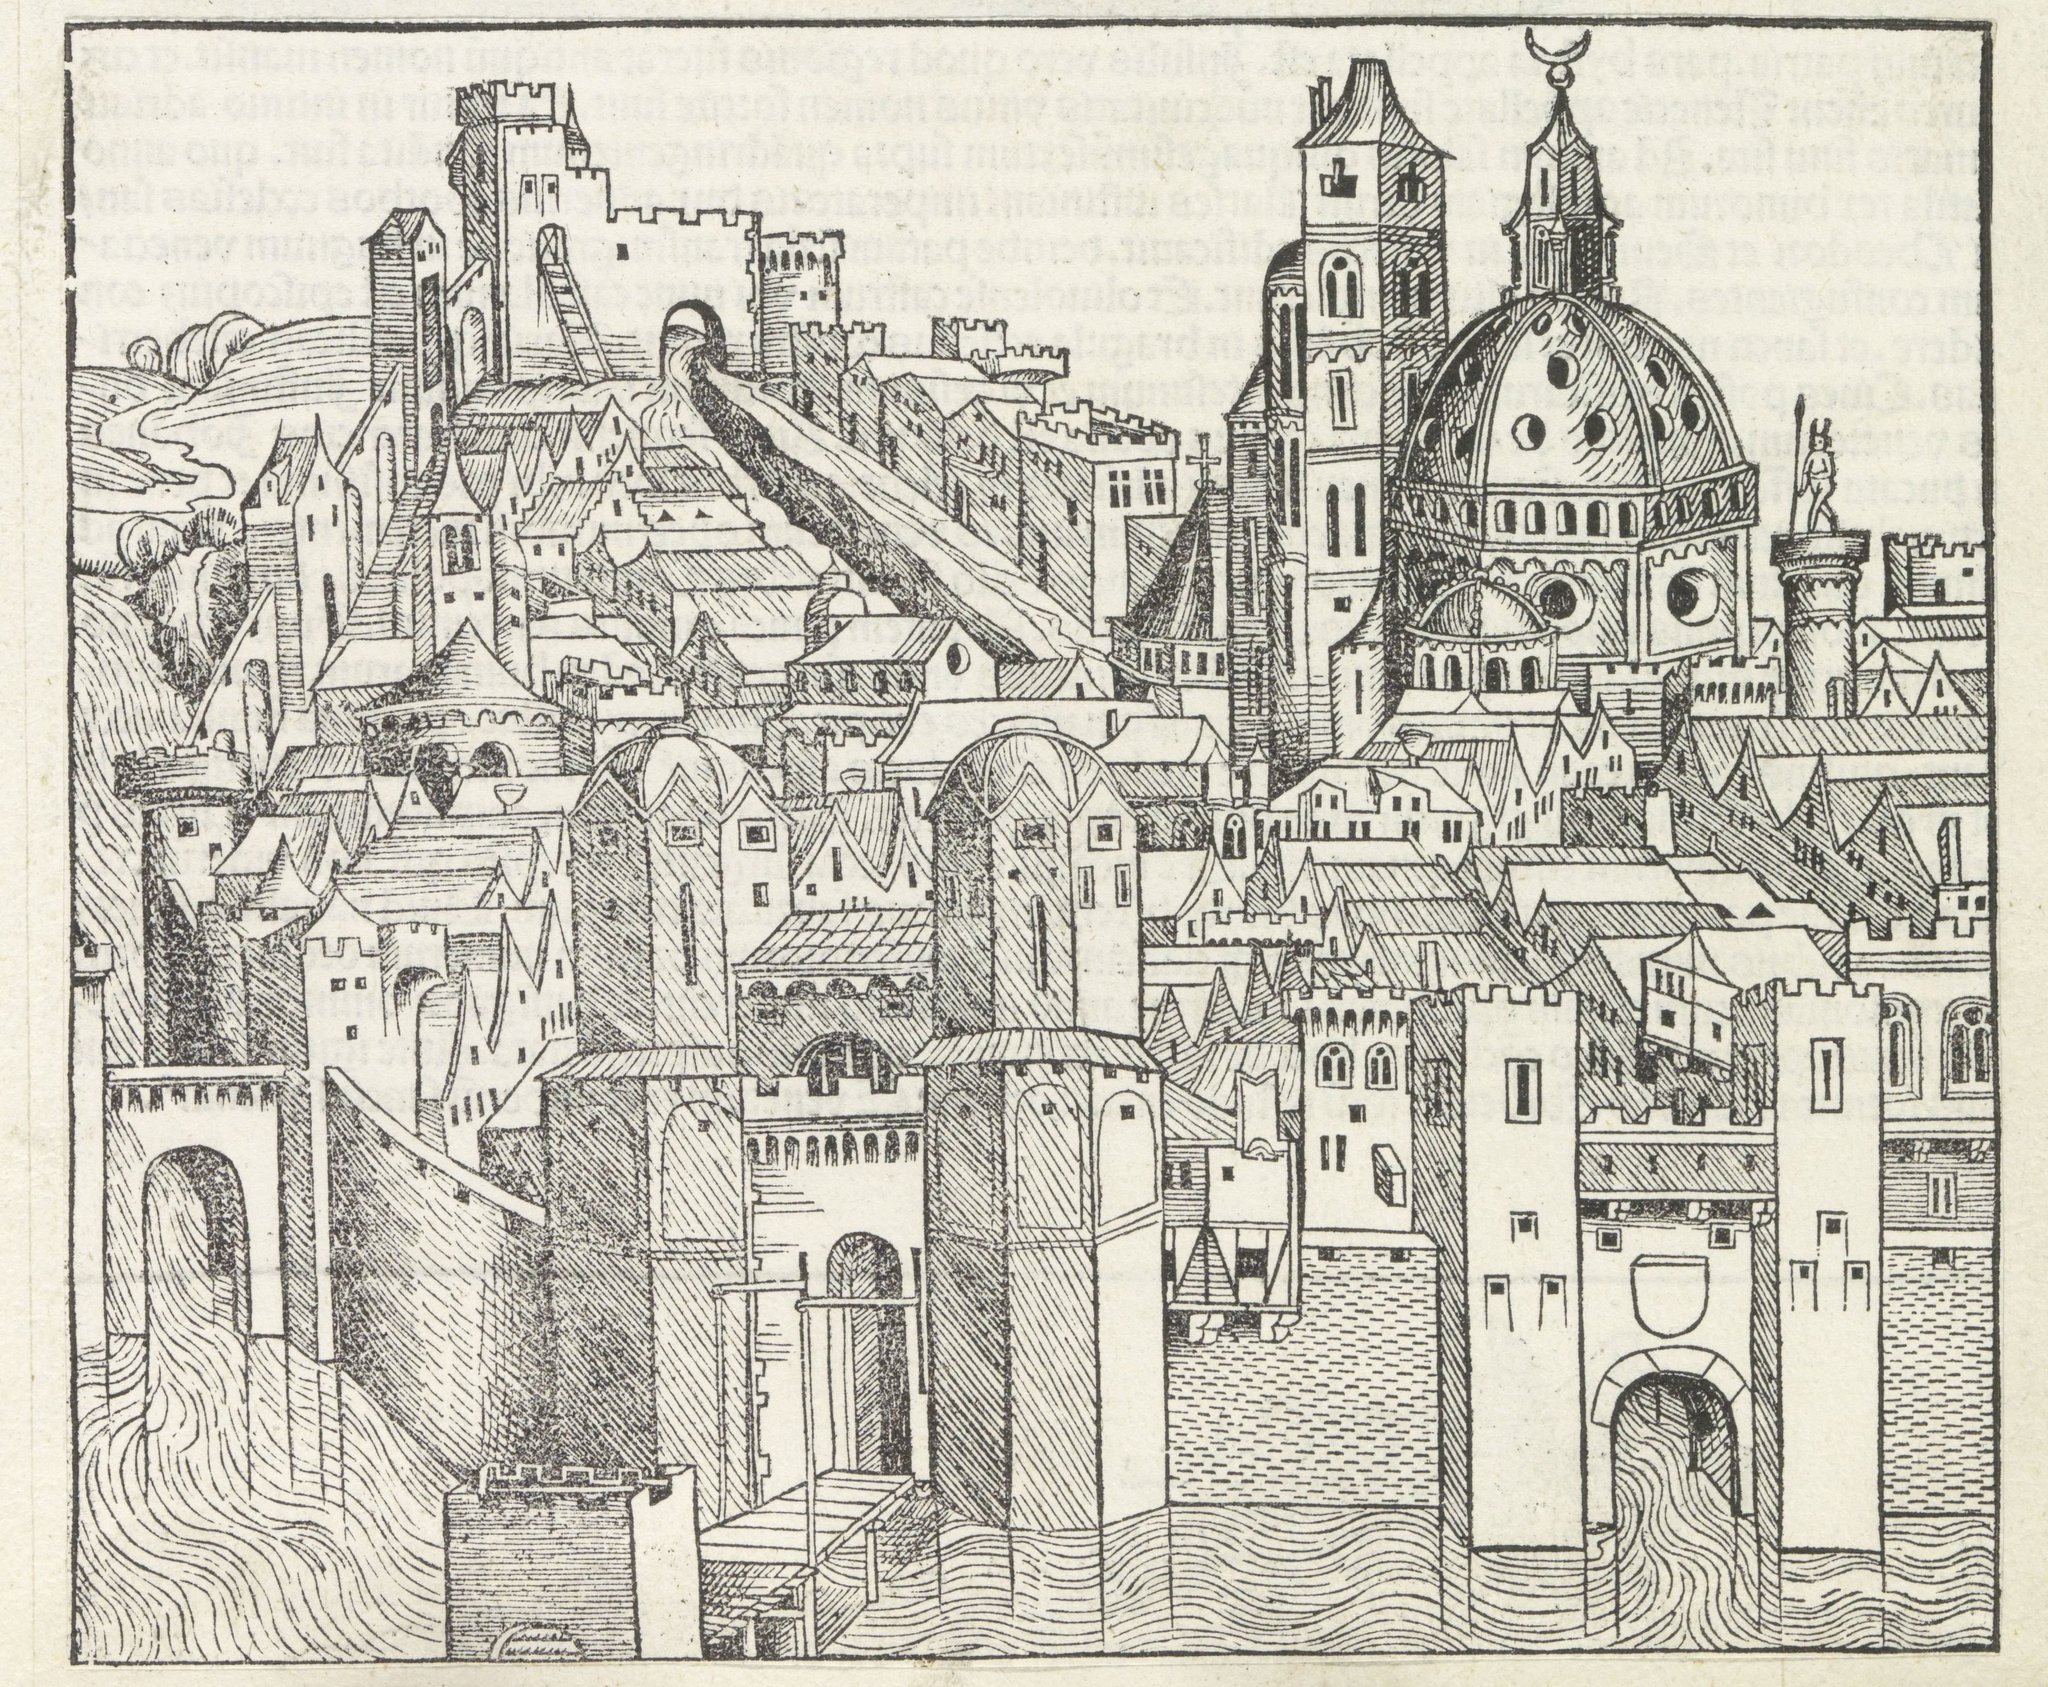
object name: book illustration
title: Liber Chronicarum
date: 1493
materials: paper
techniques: letterpress printing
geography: nuremberg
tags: city-view, and landscape with man-made constructions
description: De houtsnede wordt herhaaldelijk gebruikt als boekillustratie in de Liber Chronicarum (of Neurenbergkroniek) van Hartmann Schedel, verschenen in het Latijn en Duits in 1493. Zie de Latijnse uitgave, folio 23r, 44v, 61r, 110v en 194v.